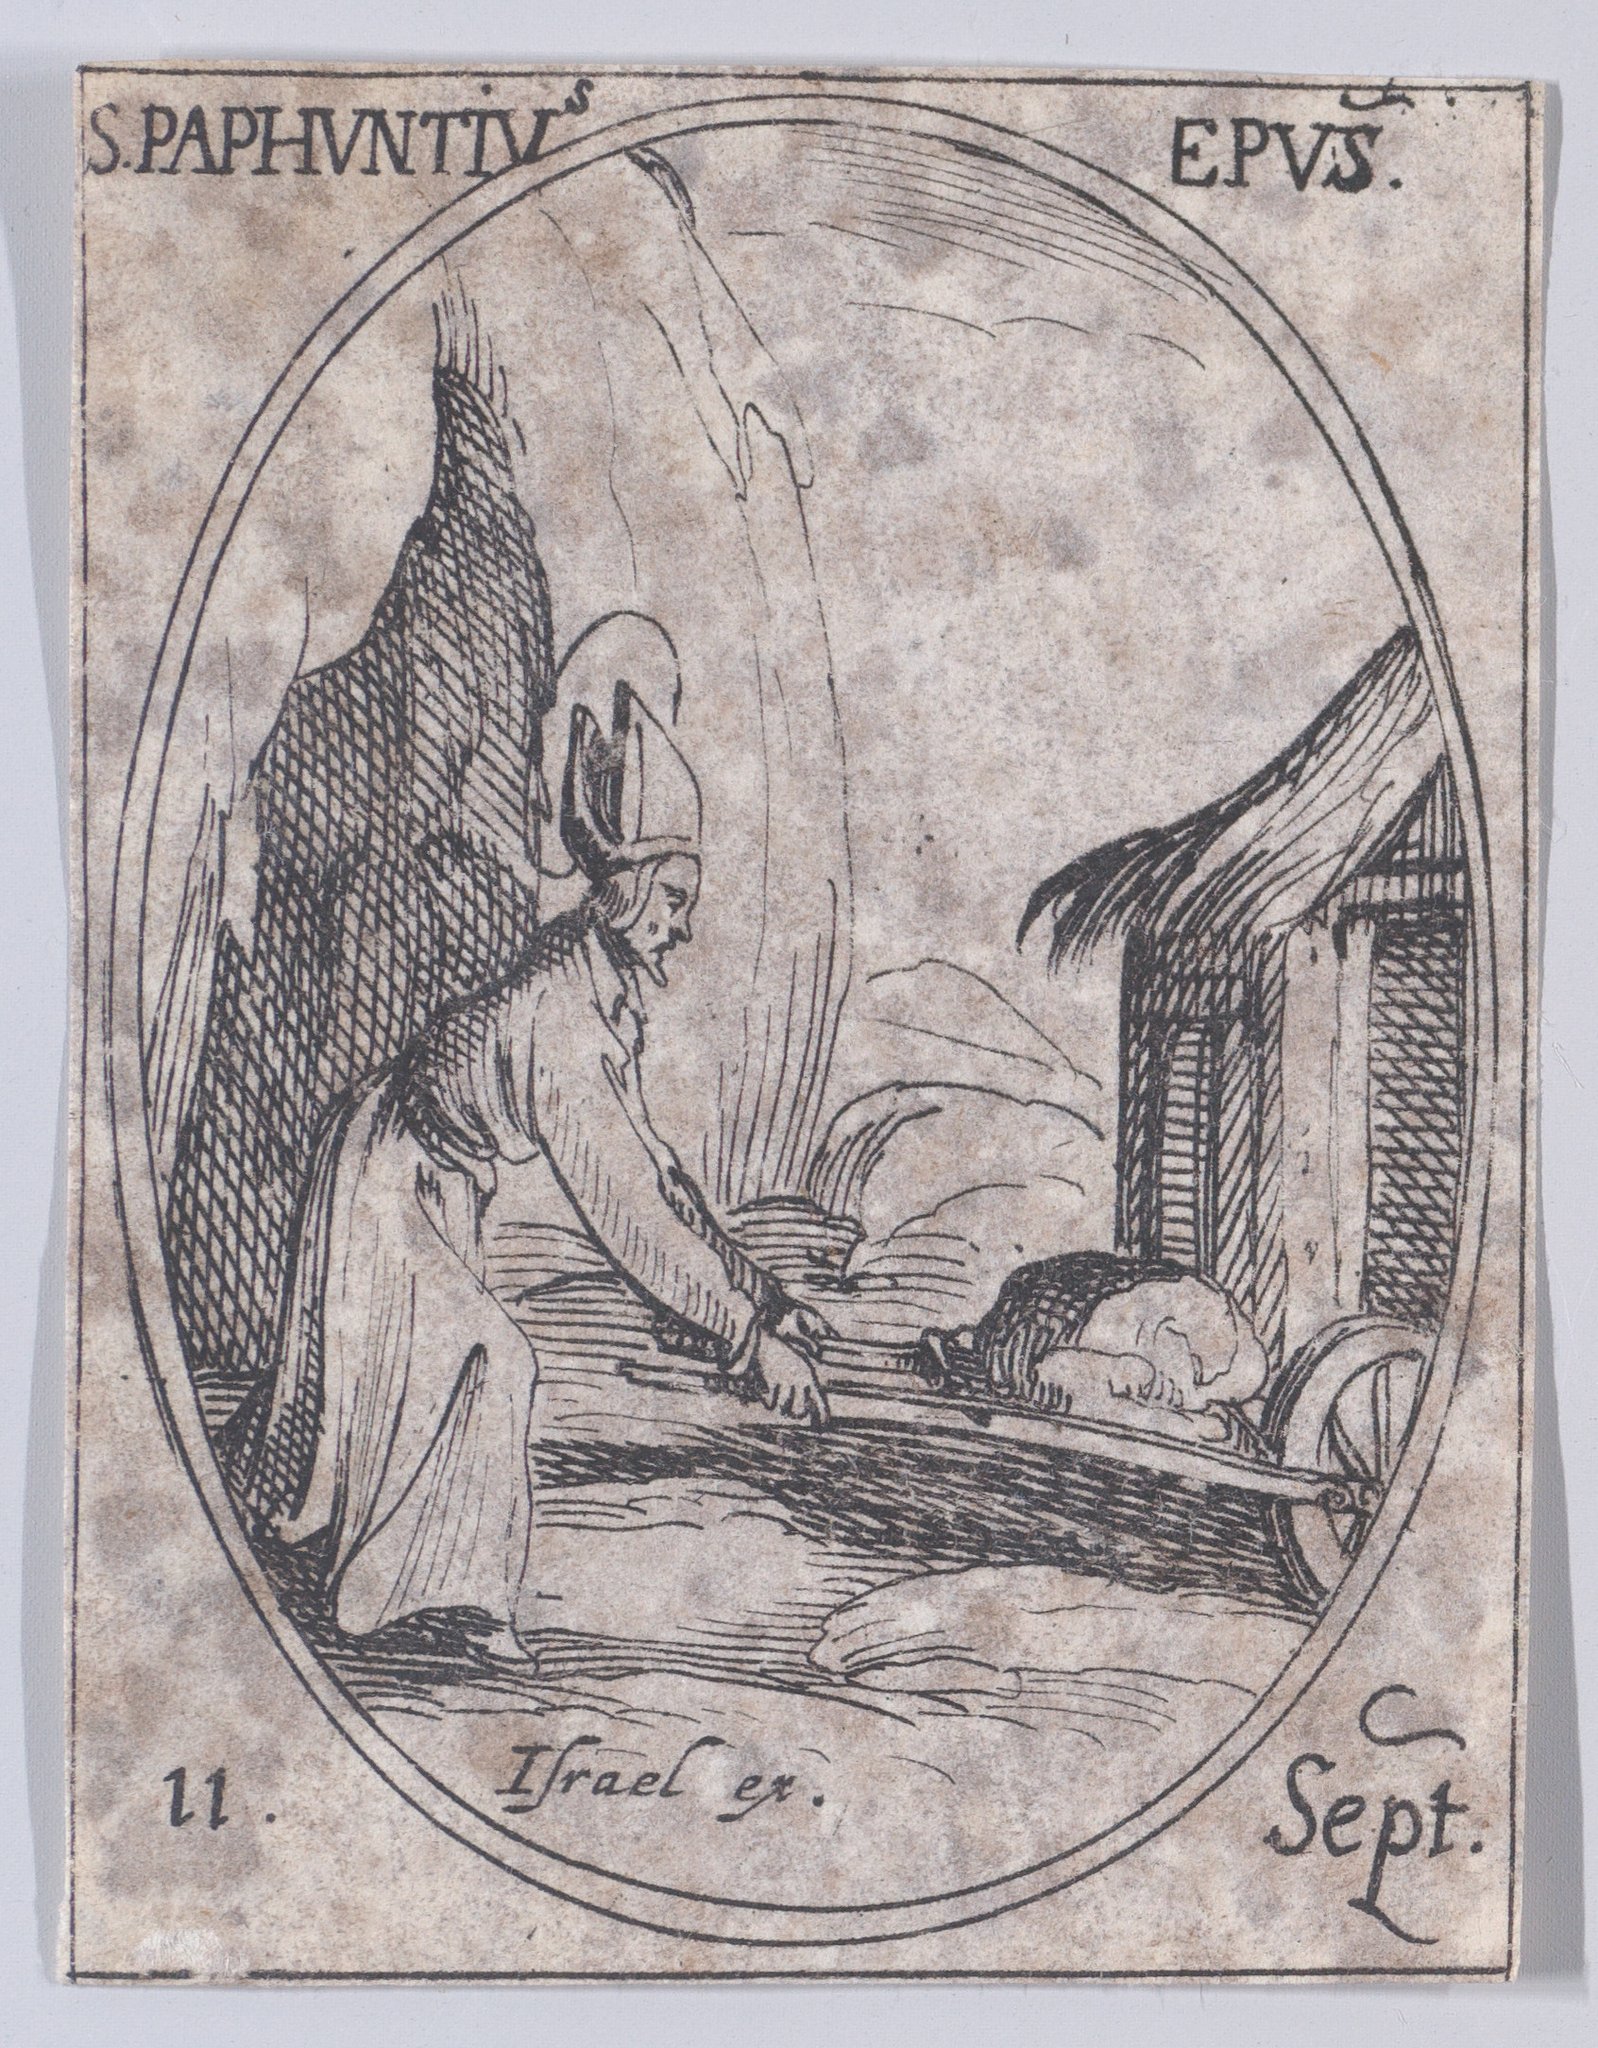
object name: print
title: S. Paphnuce, évêque (St. Paphnutius, Bishop), September 11th, from "Les Images De Tous Les Saincts et Saintes de L'Année" (Images of All of the Saints and Religious Events of the Year)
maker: jacques callot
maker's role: artist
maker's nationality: french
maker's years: 1592-1635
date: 1636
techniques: etching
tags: men,bishops,saints